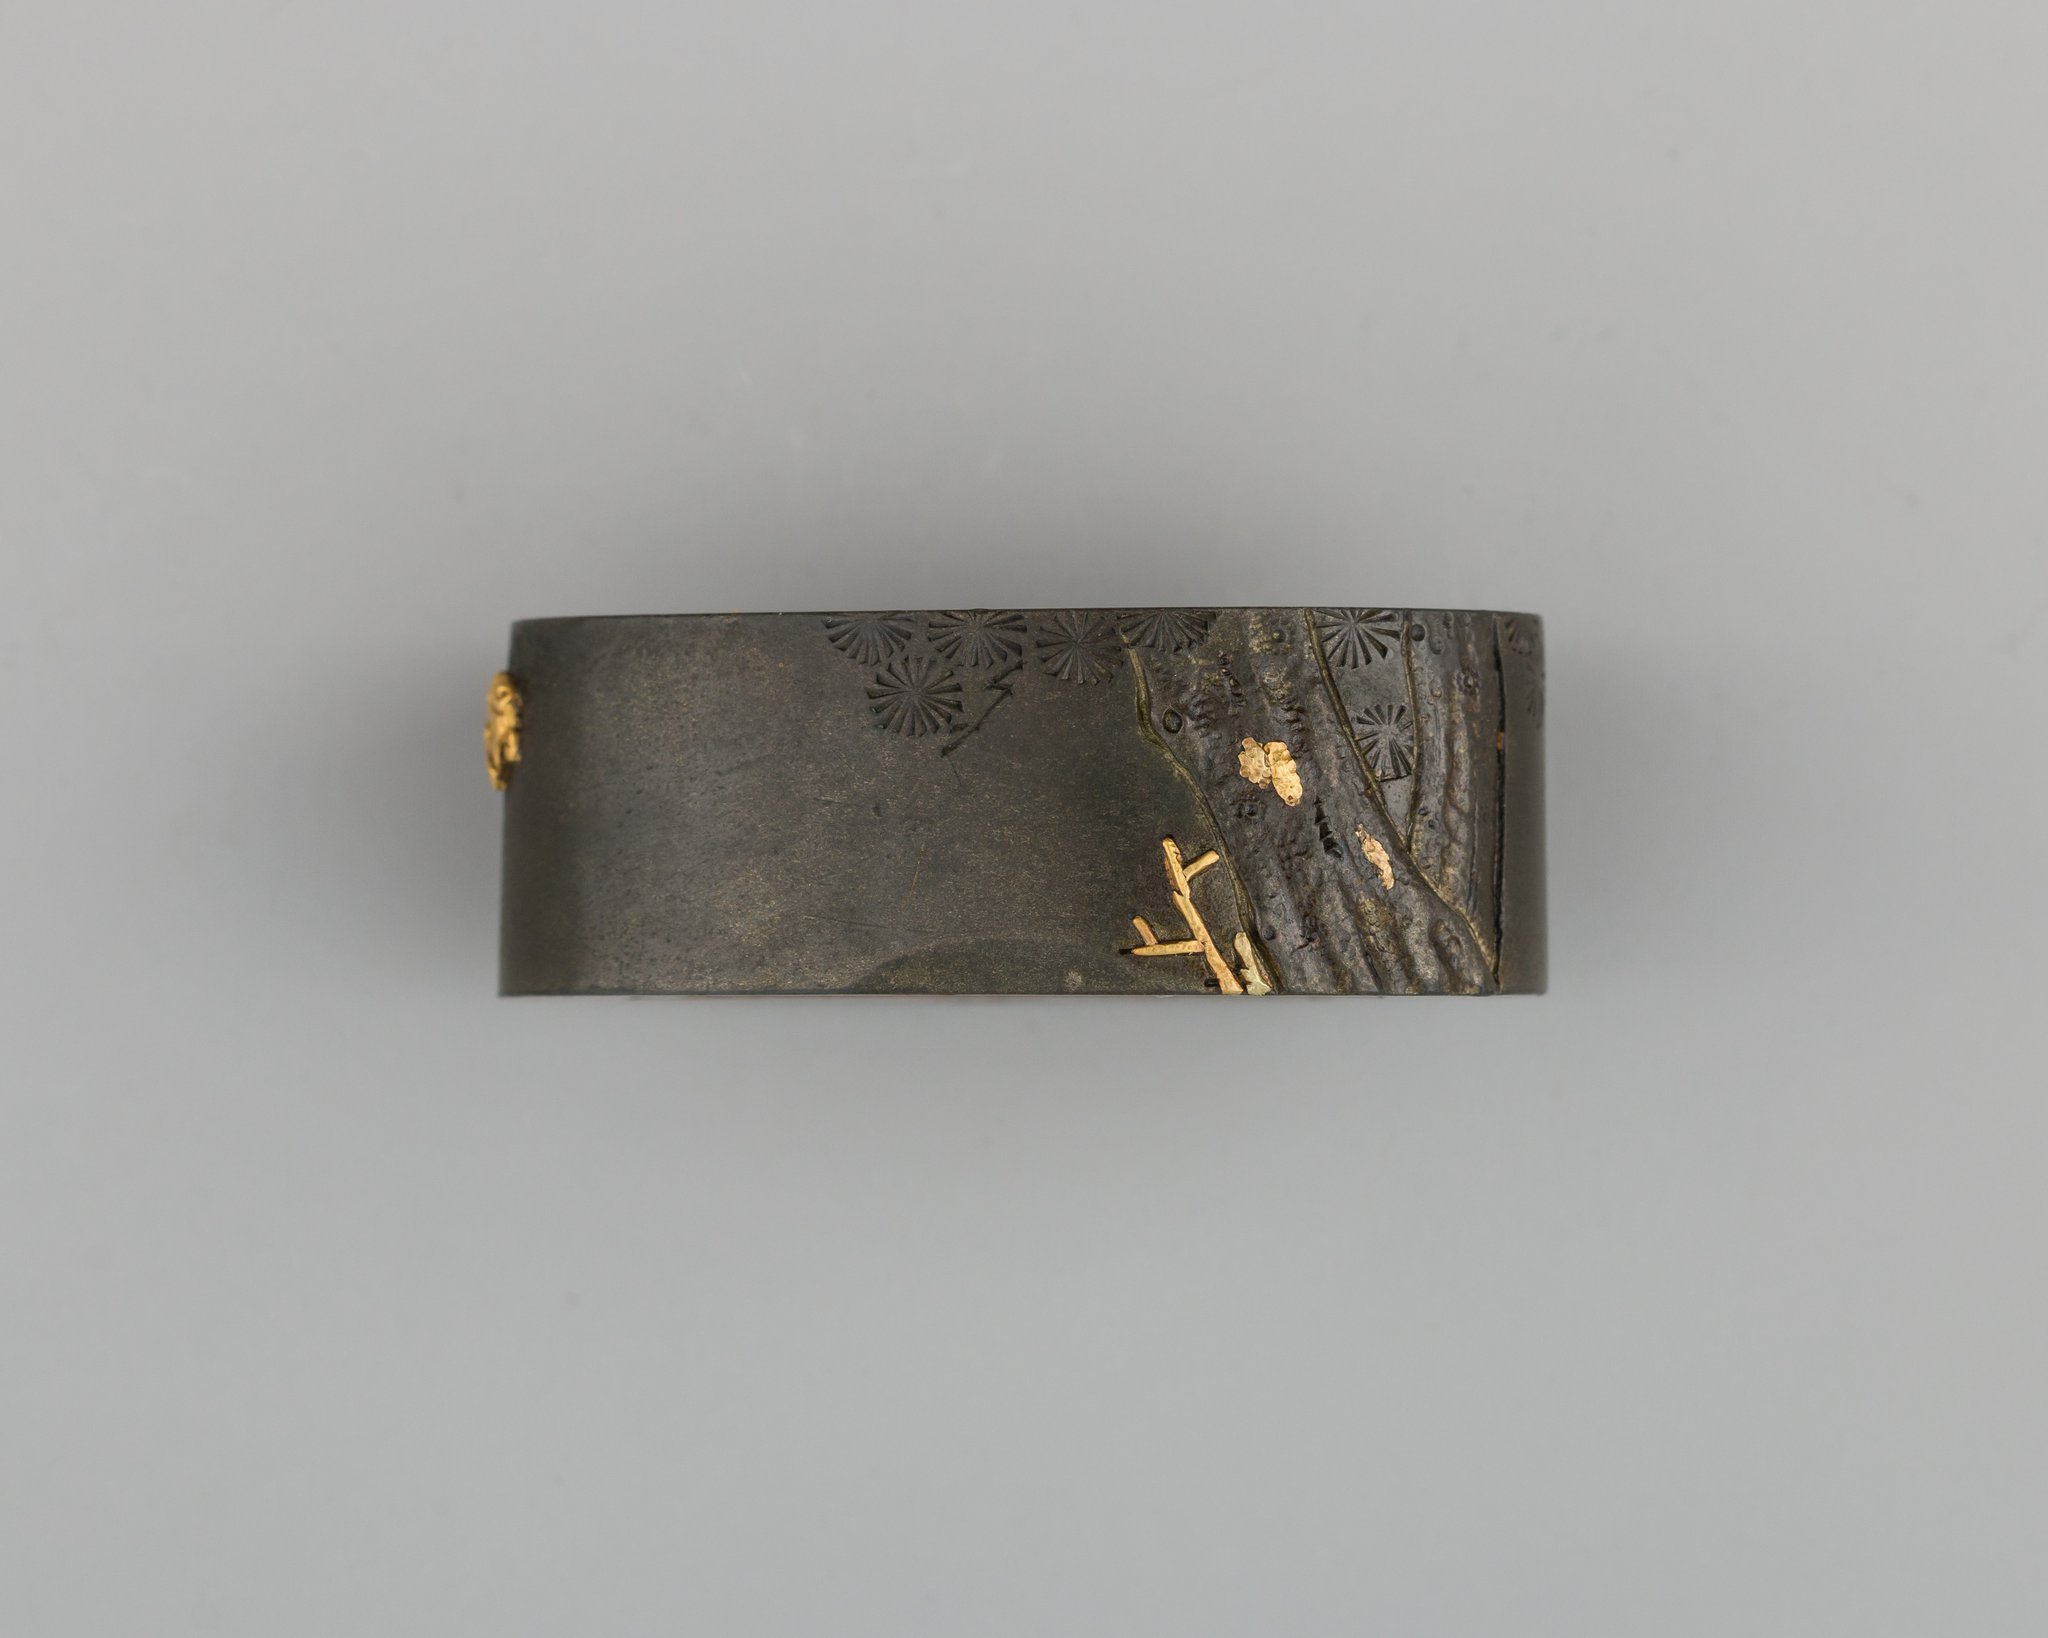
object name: sword hilt collar fuchi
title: Sword-Hilt Collar (Fuchi)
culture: japanese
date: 1615-1868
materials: silver alloy, gold, silver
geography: japan